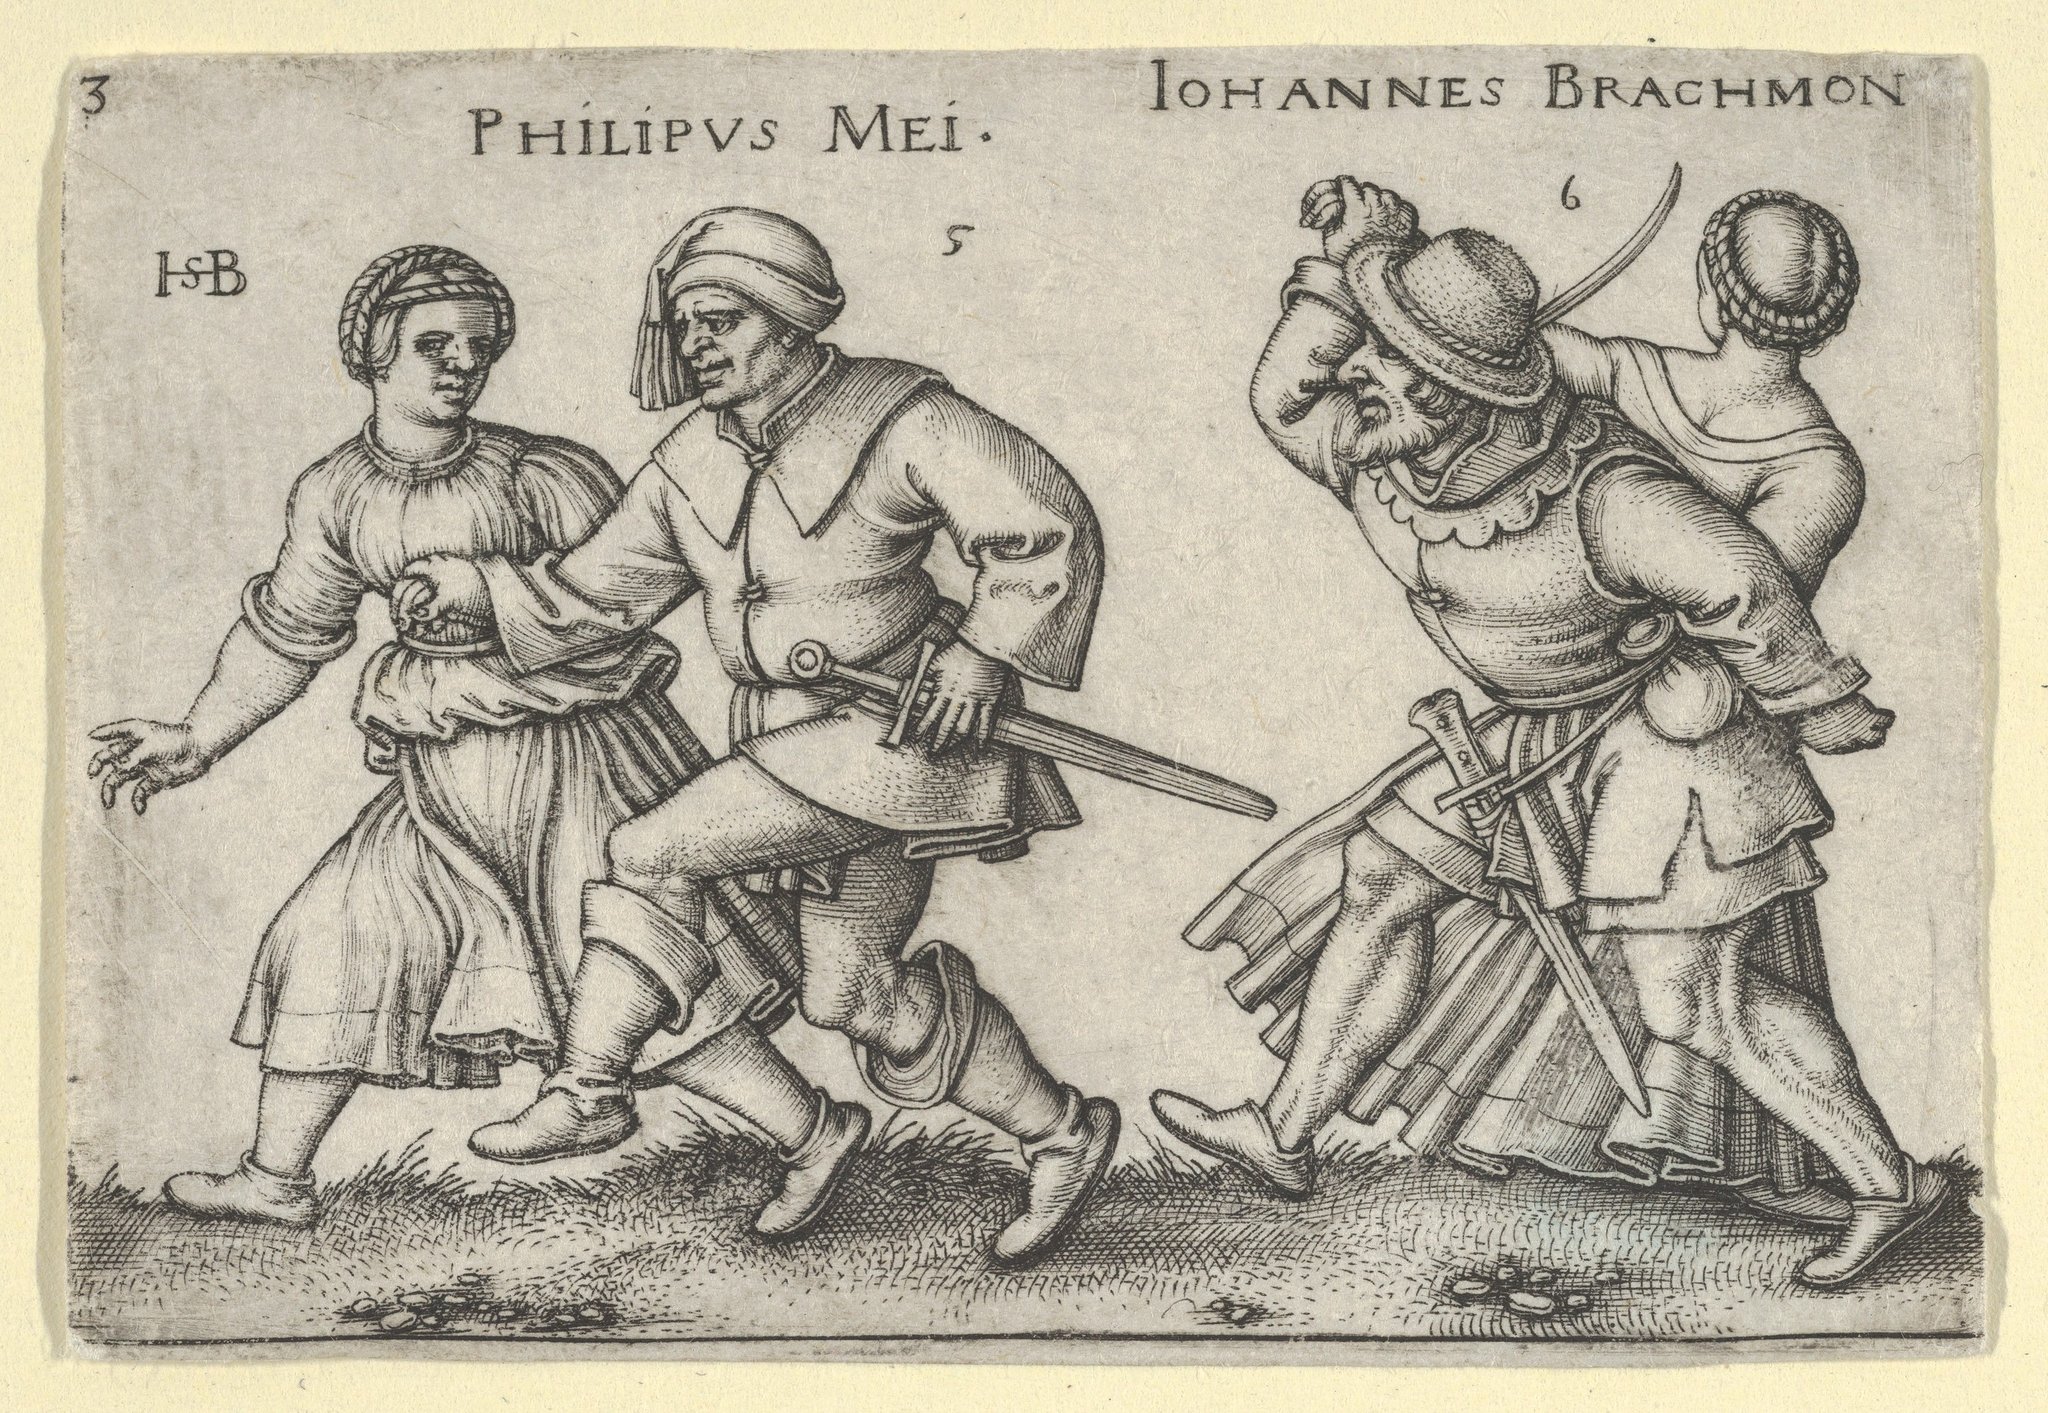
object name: print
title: May and June from "The Peasants' Feast" or "The Twelve Months"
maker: sebald beham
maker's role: artist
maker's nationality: german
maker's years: 1500-1550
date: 1546-1547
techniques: engraving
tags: swords,men,women